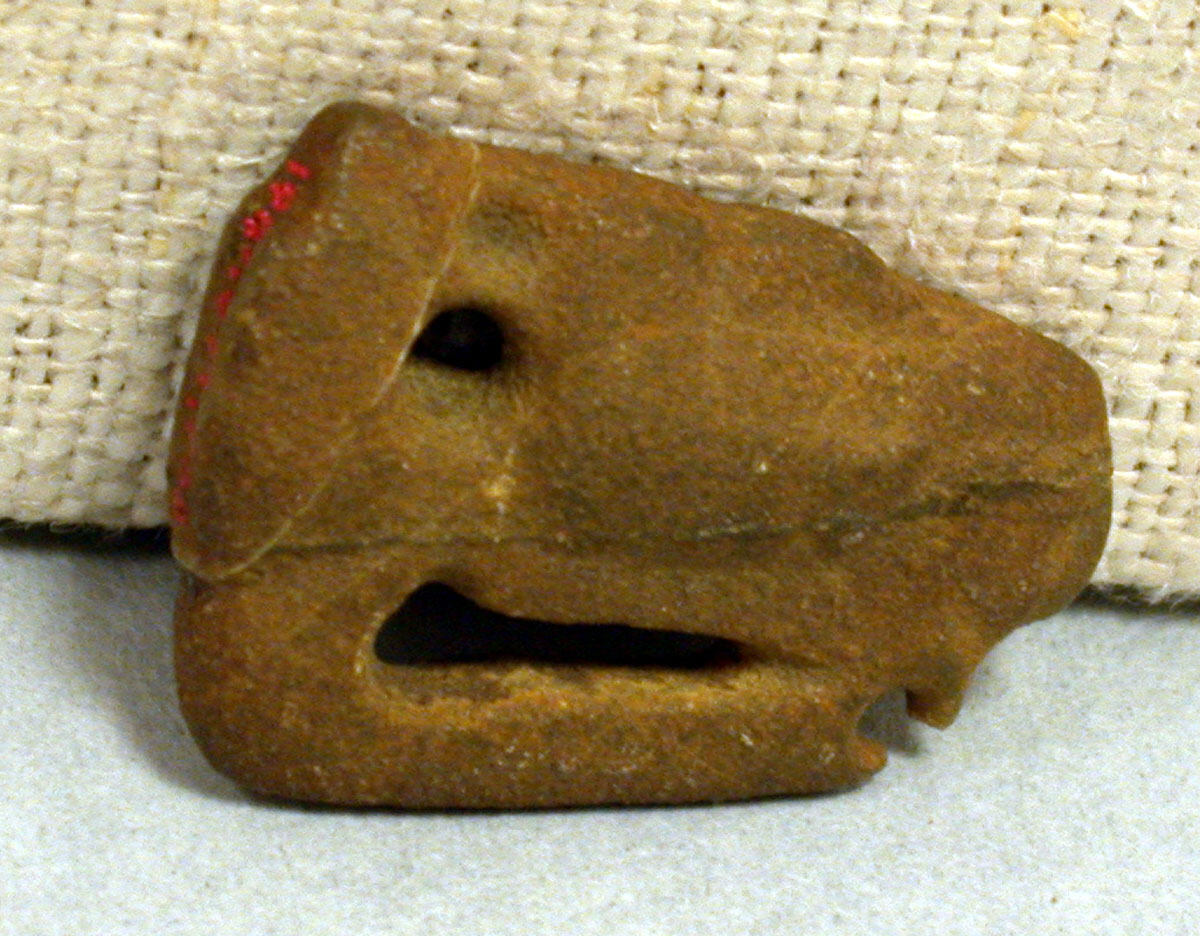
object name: pendant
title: Stone Animal Pendant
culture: costa rican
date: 801-1500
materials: stone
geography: costa rica